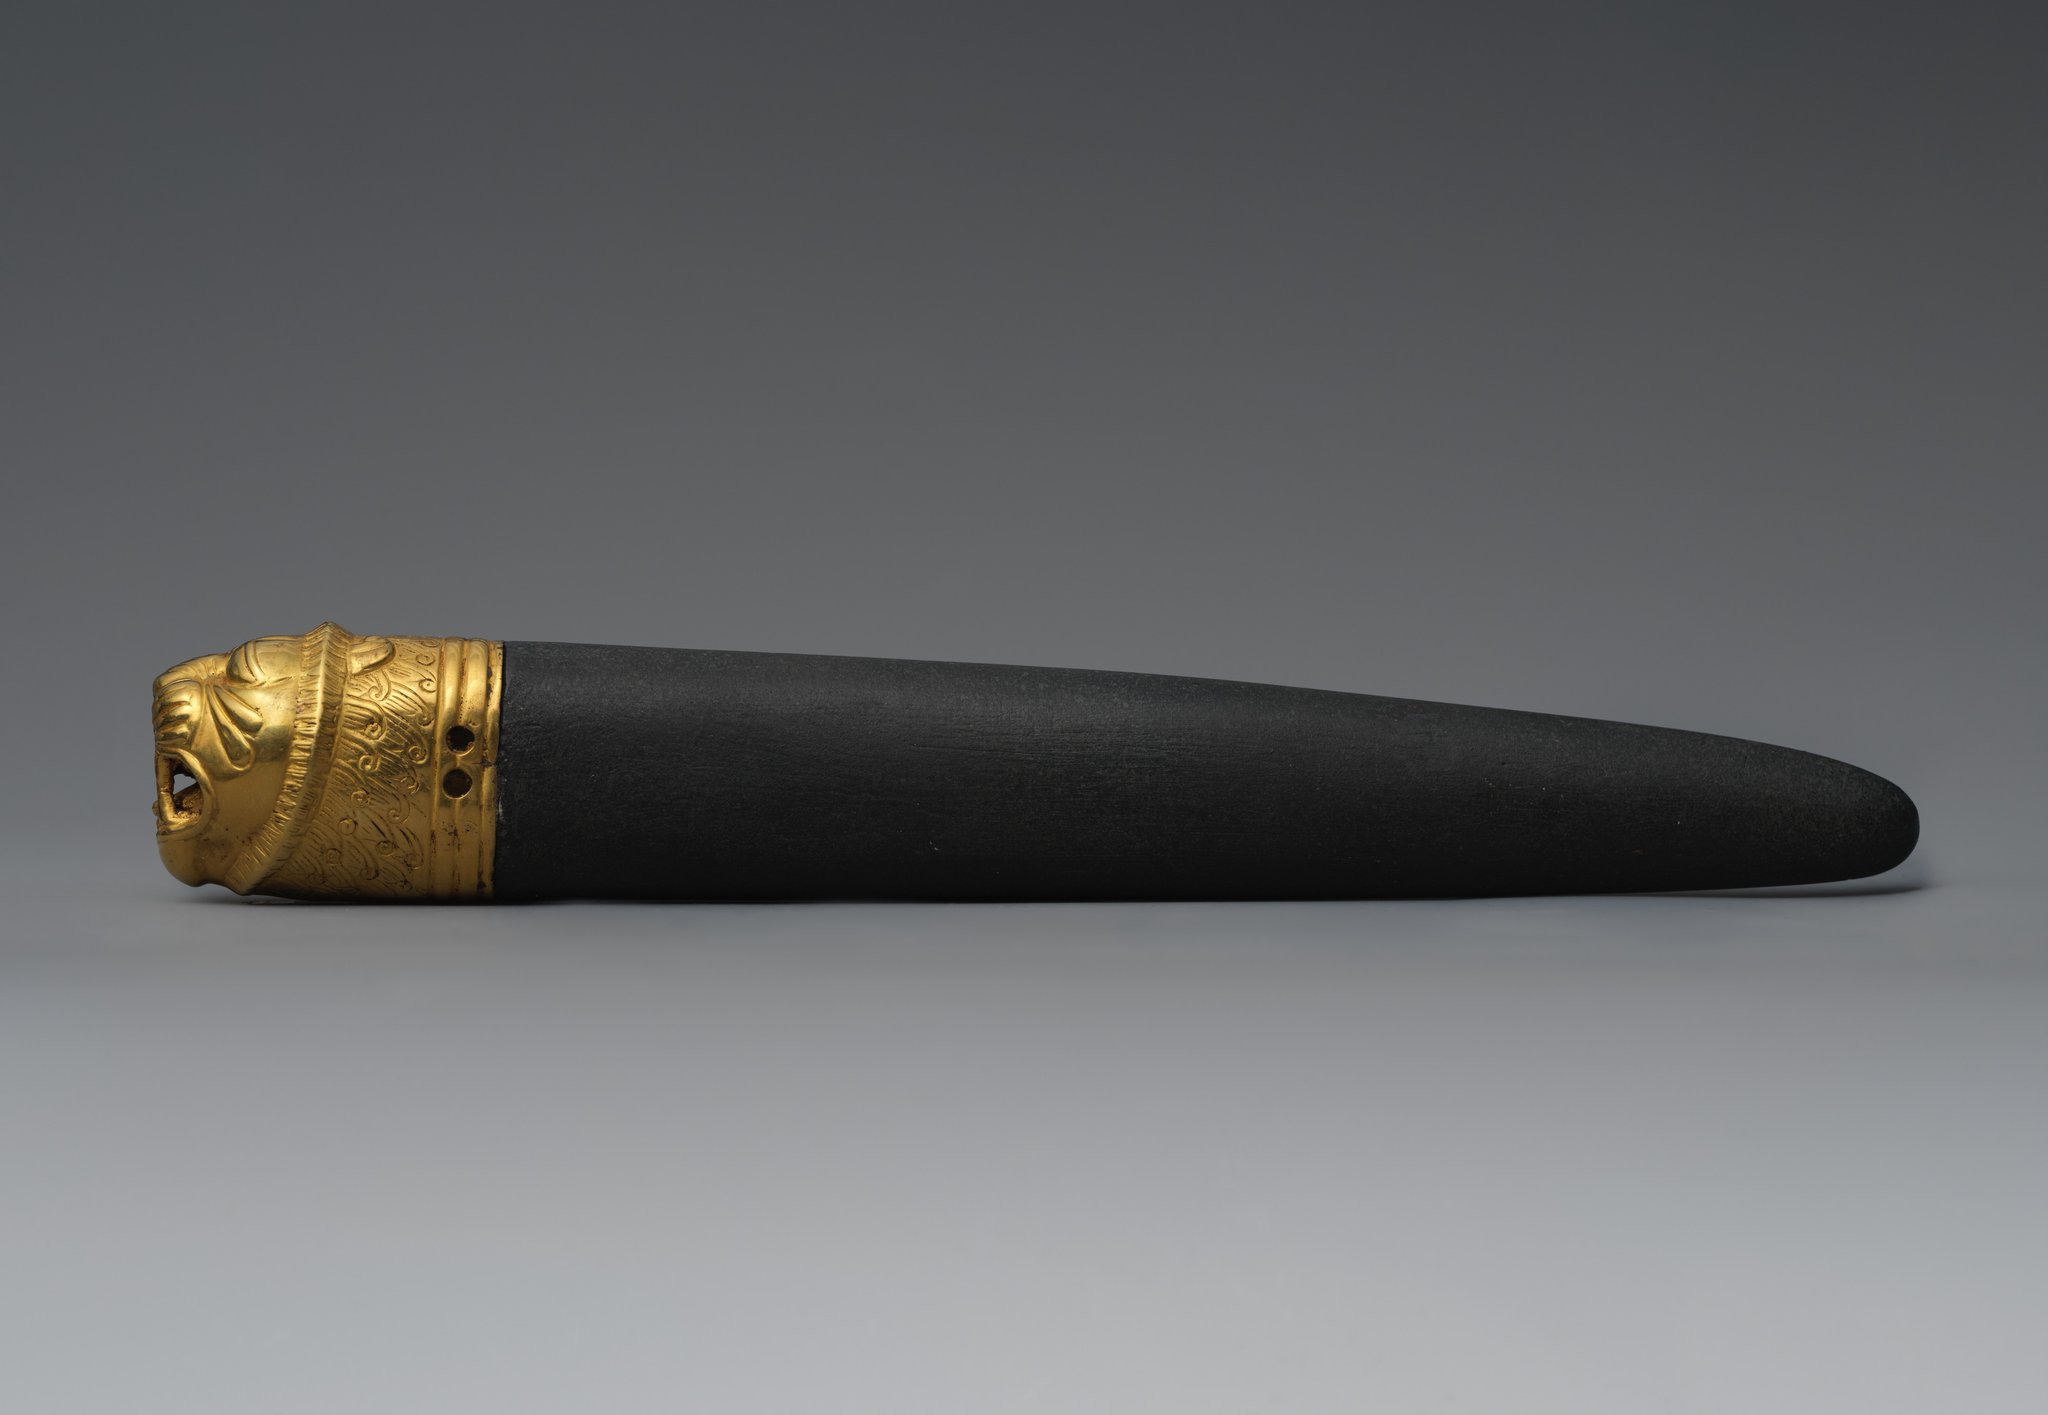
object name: sculpture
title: Lion head mounted on a modern whetstone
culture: achaemenid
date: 600-301 BCE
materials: gold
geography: iran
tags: lions